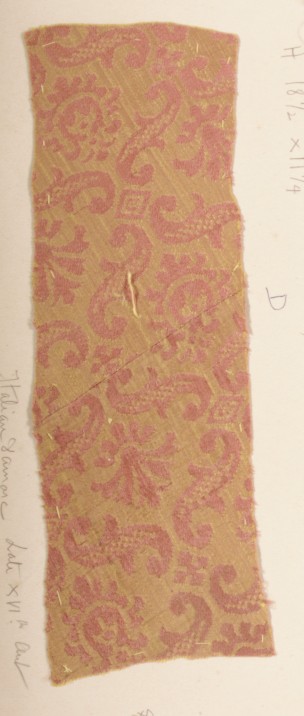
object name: fragment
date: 1567-1600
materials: silk